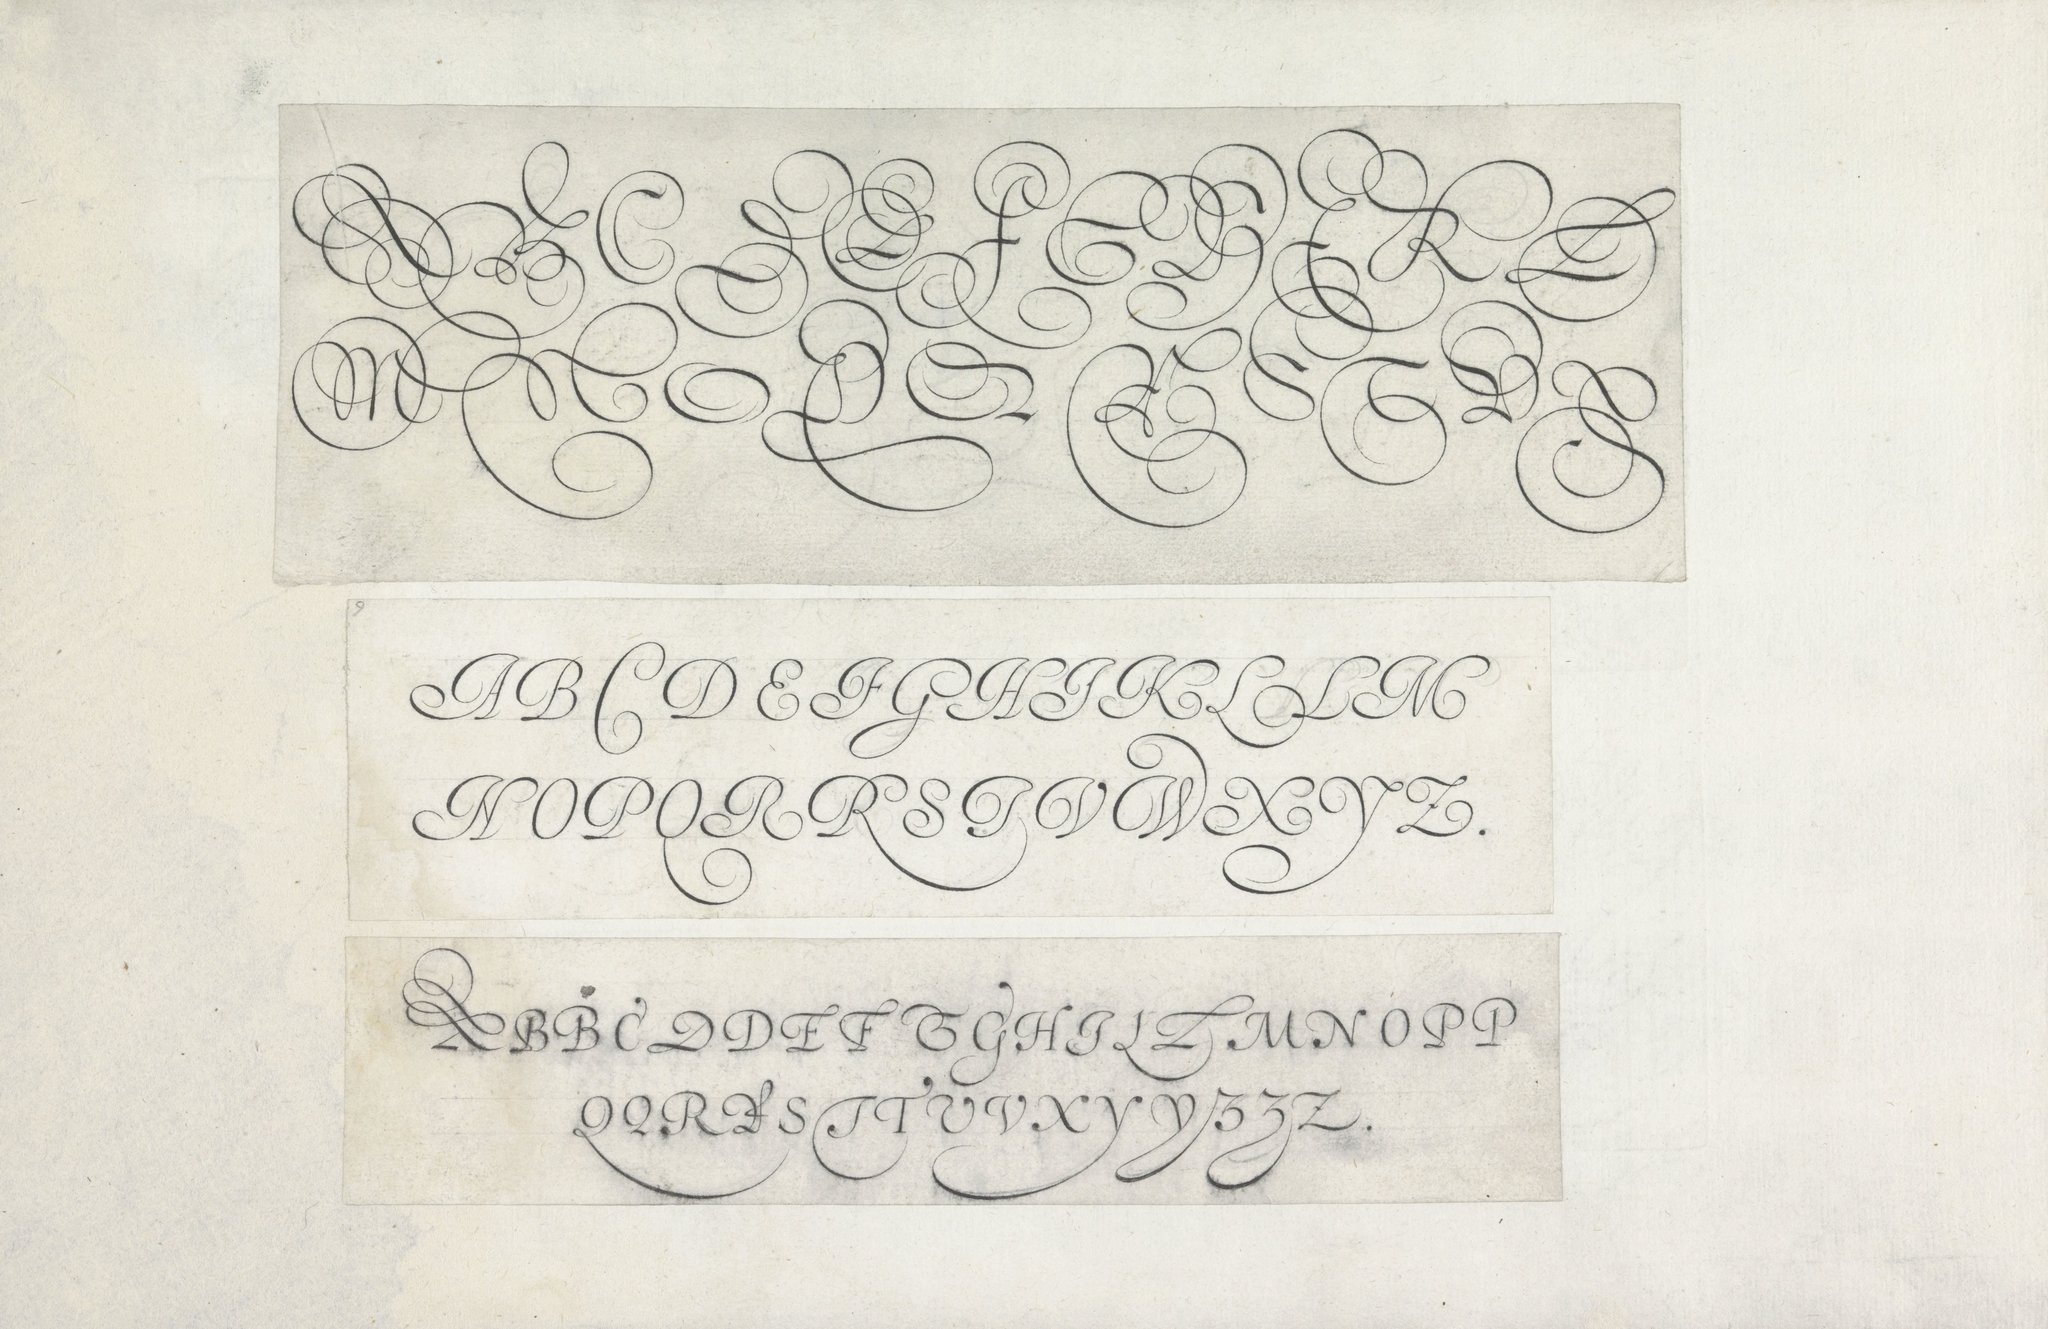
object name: drawing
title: Drie ontwerpen van schrijfvoorbeelden: het alfabet in kapitalen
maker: jan van de velde (i)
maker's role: painter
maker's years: 1568-1623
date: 1605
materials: ink, paper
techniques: calligraphy, pen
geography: rotterdam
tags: calligraphy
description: Drie voorstellingen op een albumblad. Het gaat om kalligrafische tekeningen met het alfabet in kapitalen. De tekeningen maken deel uit van een album.